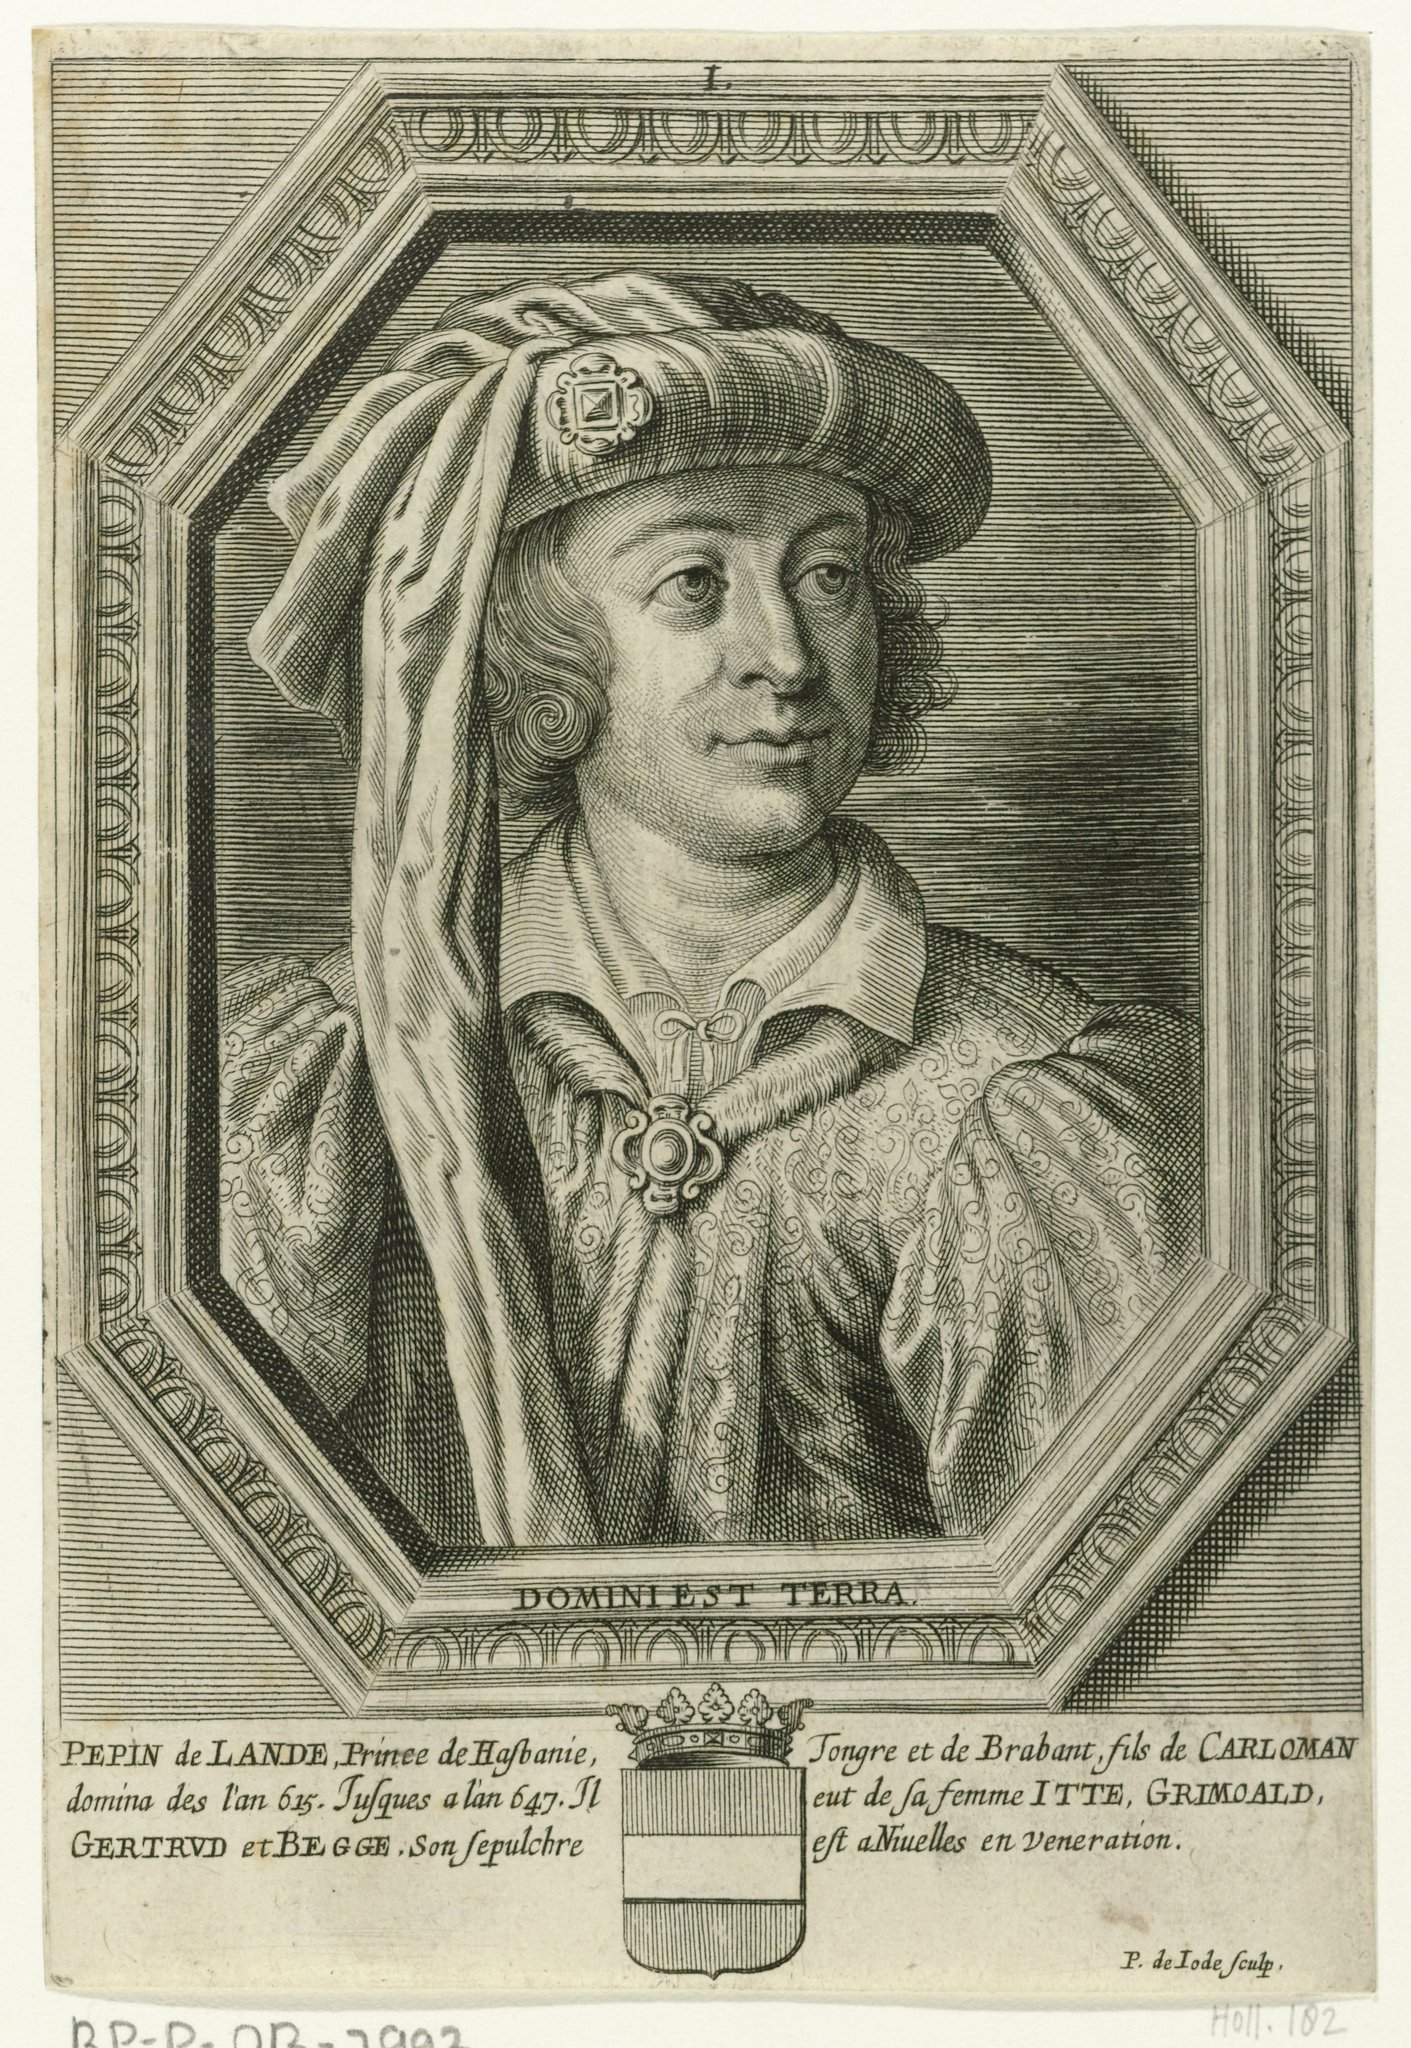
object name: print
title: Portret van Pepijn van Landen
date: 1661-1663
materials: paper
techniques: engraving, etching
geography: antwerp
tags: pepijn van landen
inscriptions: collector's mark: Lugt 240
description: Busteportret van Pepijn van Landen, met tulband. Het portret is gevat in een achthoekige omlijsting met een motto in het Latijn. In de marge het wapenschild van de geportretteerde en een drieregelig onderschrift in het Frans. Prent uit een boek waarin 54 prenten met portretten.